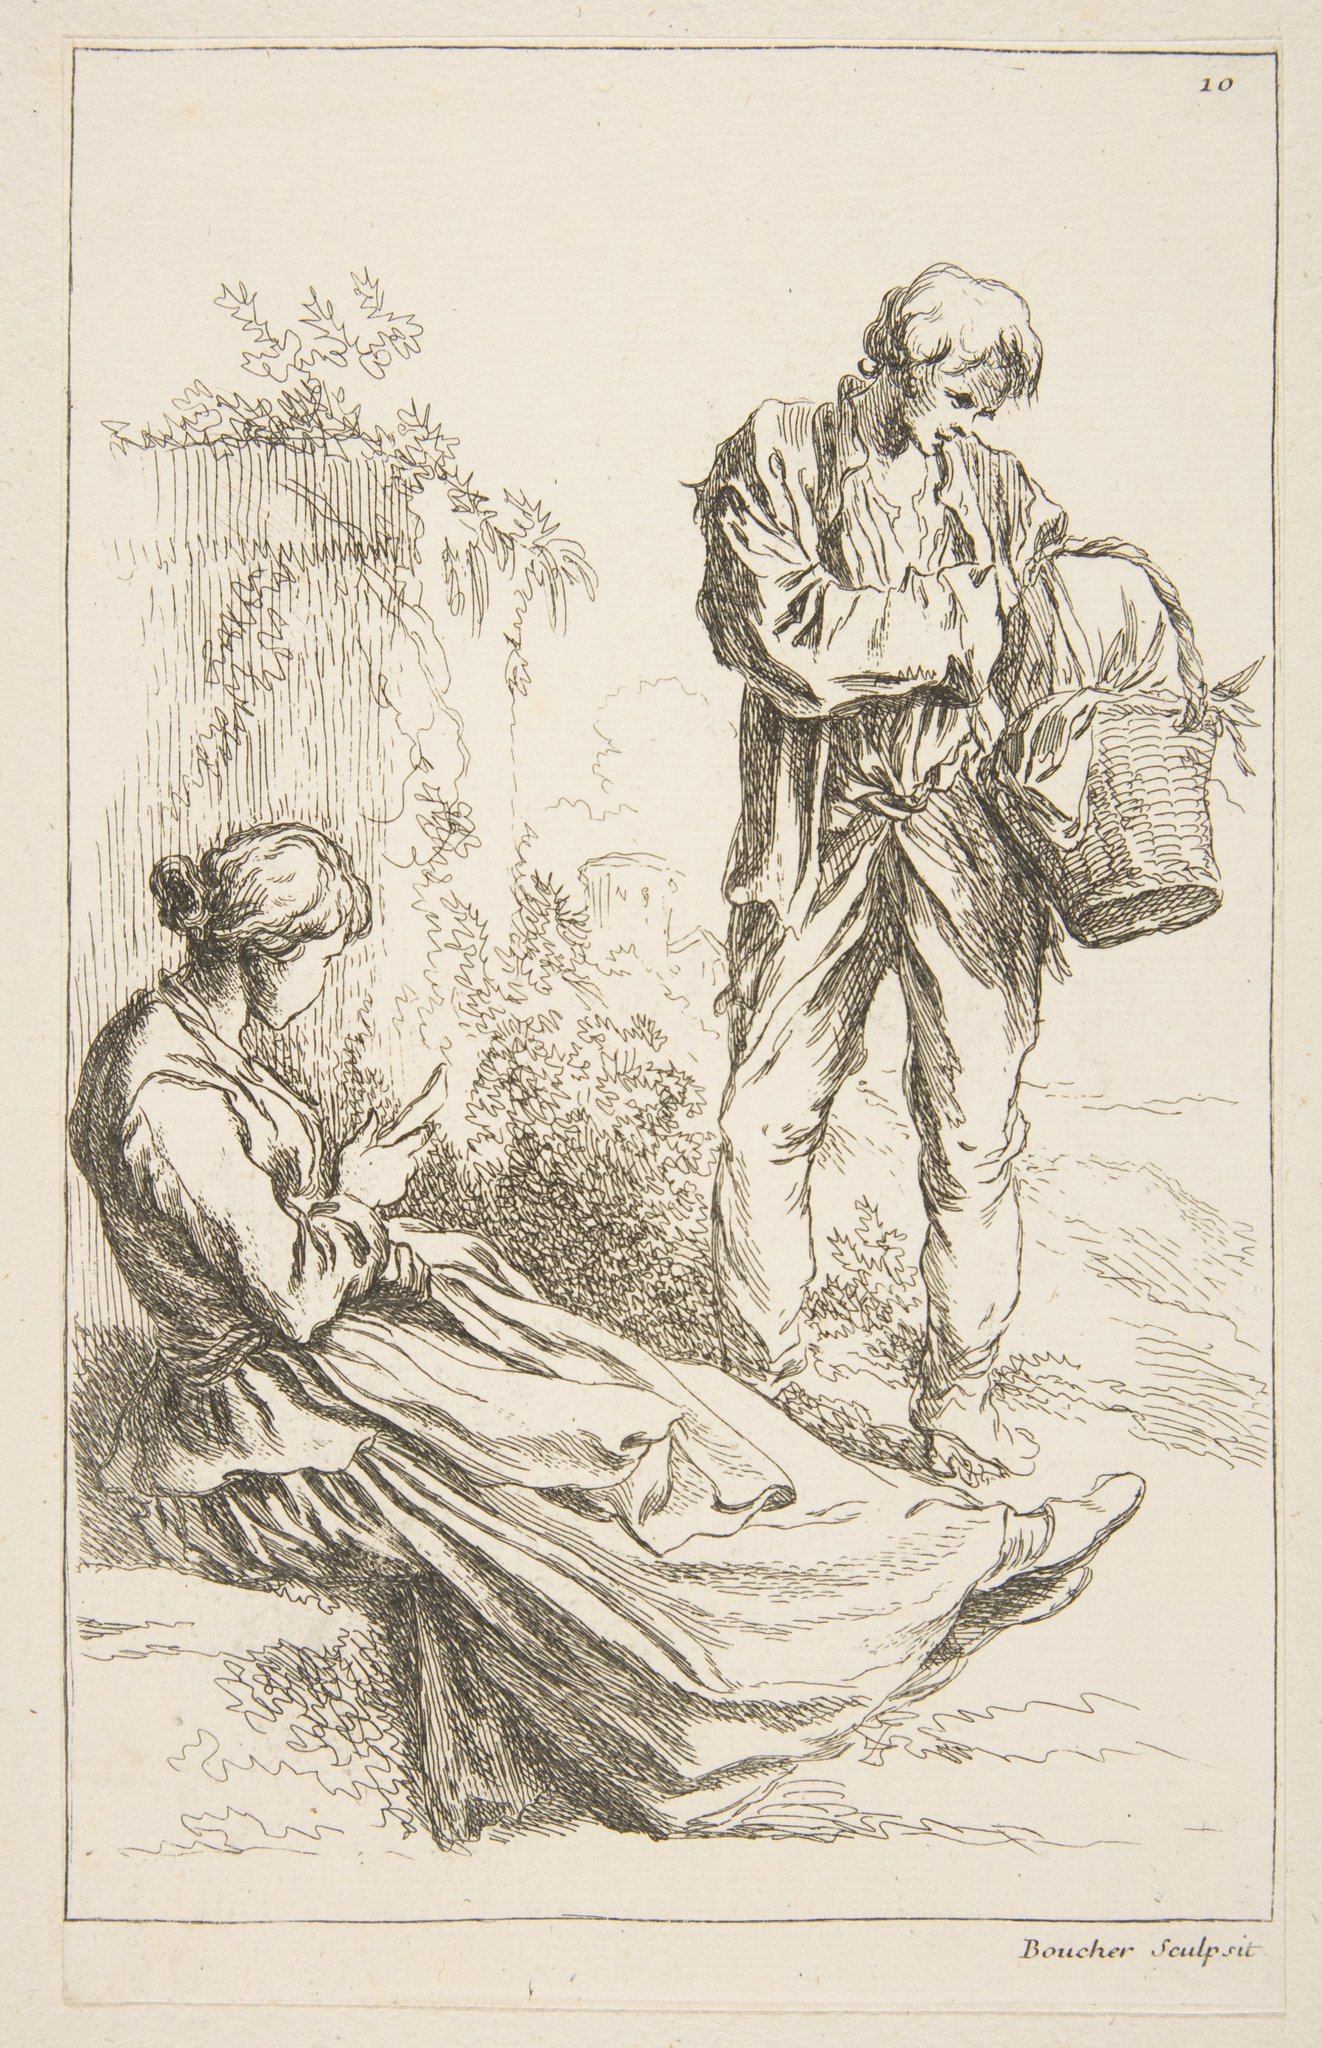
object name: print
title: Sheet of Sketches, from "Livre d’étude d’après les desseins originaux de Blomart"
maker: françois boucher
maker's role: artist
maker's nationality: french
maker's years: 1703-1770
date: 1735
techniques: etching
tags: men,women